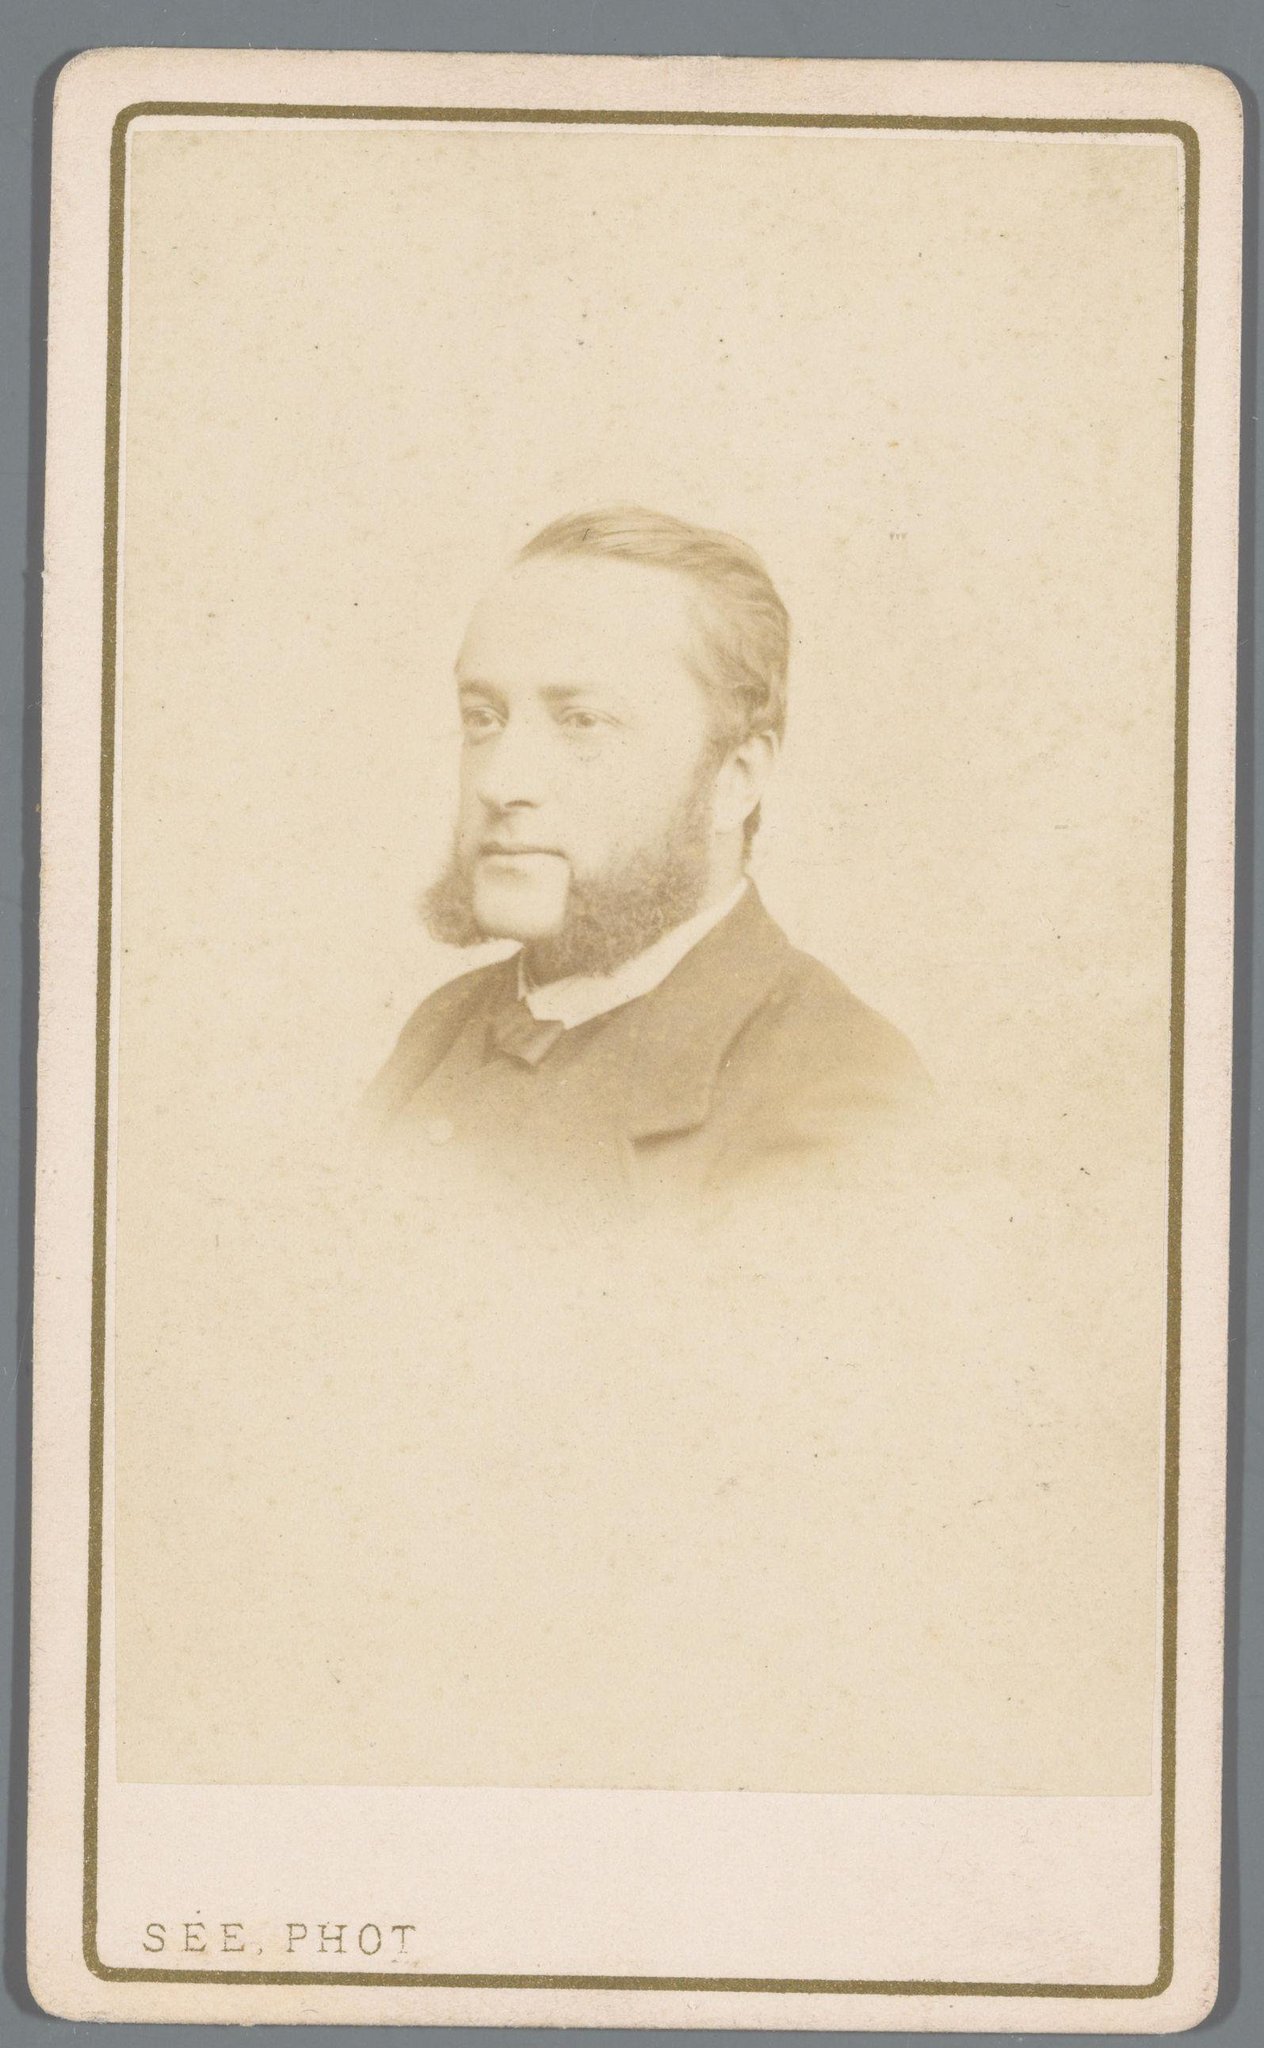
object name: carte de visite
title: Portret van een onbekende man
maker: gerson sée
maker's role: fotograaf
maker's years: 1823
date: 1862-1865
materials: cardboard, paper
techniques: albumen print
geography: paris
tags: adult man, anonymous historical person portrayed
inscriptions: number: ‘12989’, inscription: ‘Pour avoir des Portraits semblables/ reppeler le No’, address: ‘7, BOULd DE STRASBOURG AU 1er/ PARIS’